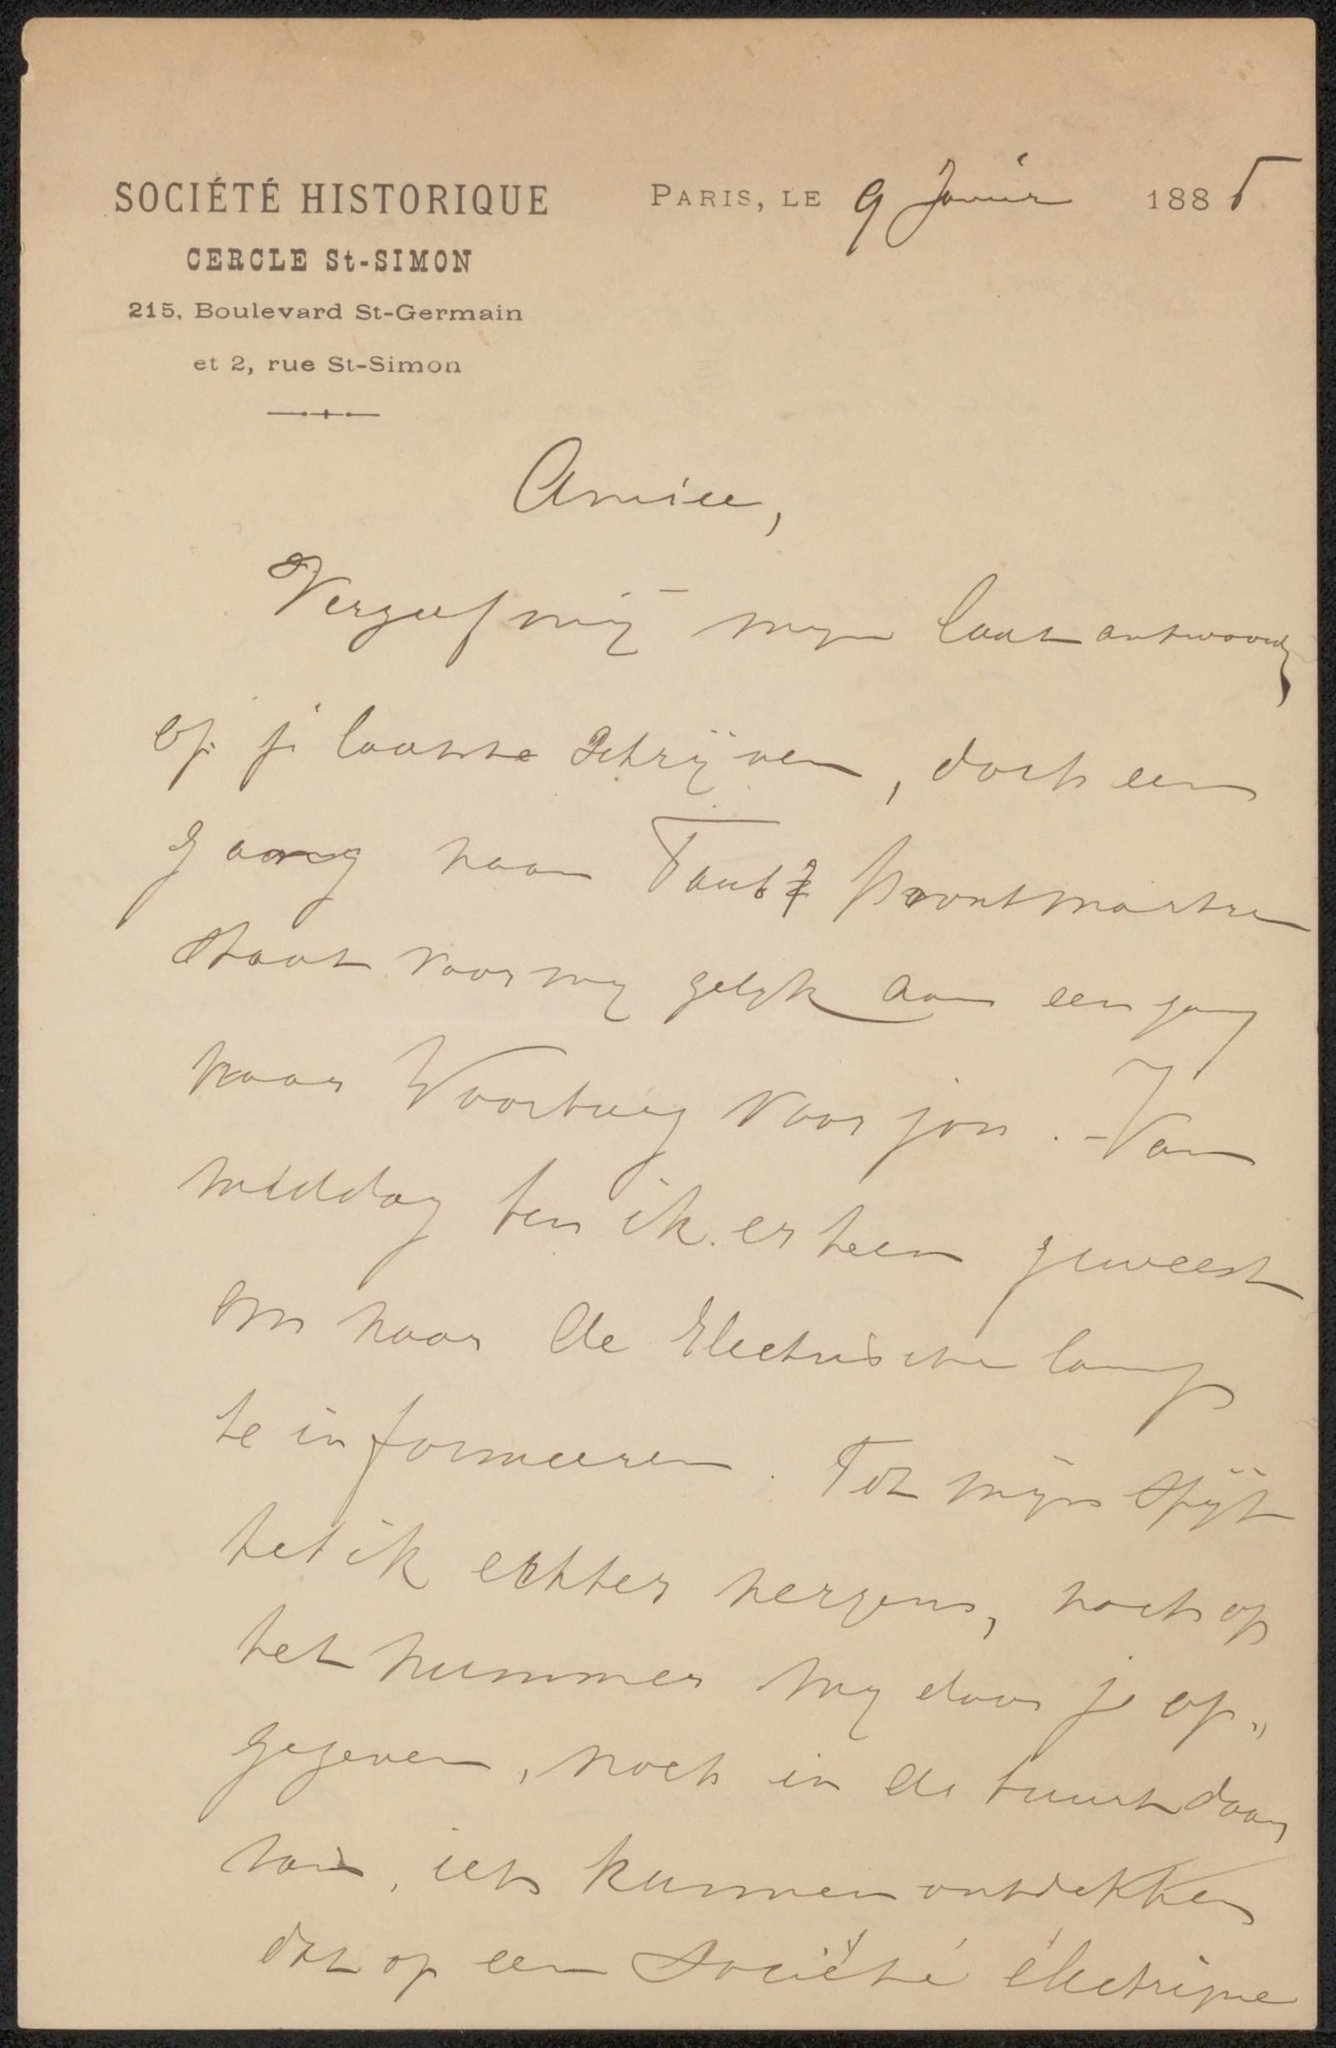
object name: letter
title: Brief aan Philip Zilcken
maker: adriaan pit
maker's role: print maker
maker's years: 1860-1944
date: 1886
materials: ink, paper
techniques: pen, printing, writing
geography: paris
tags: utrecht, print maker, draughtsman, johan philip van der kellen, rijksmuseum amsterdam, paris, painter, philip zilcken, literature ~ arts, the graphic arts, art collecting, voorburg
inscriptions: collector's mark: ‘RPK’